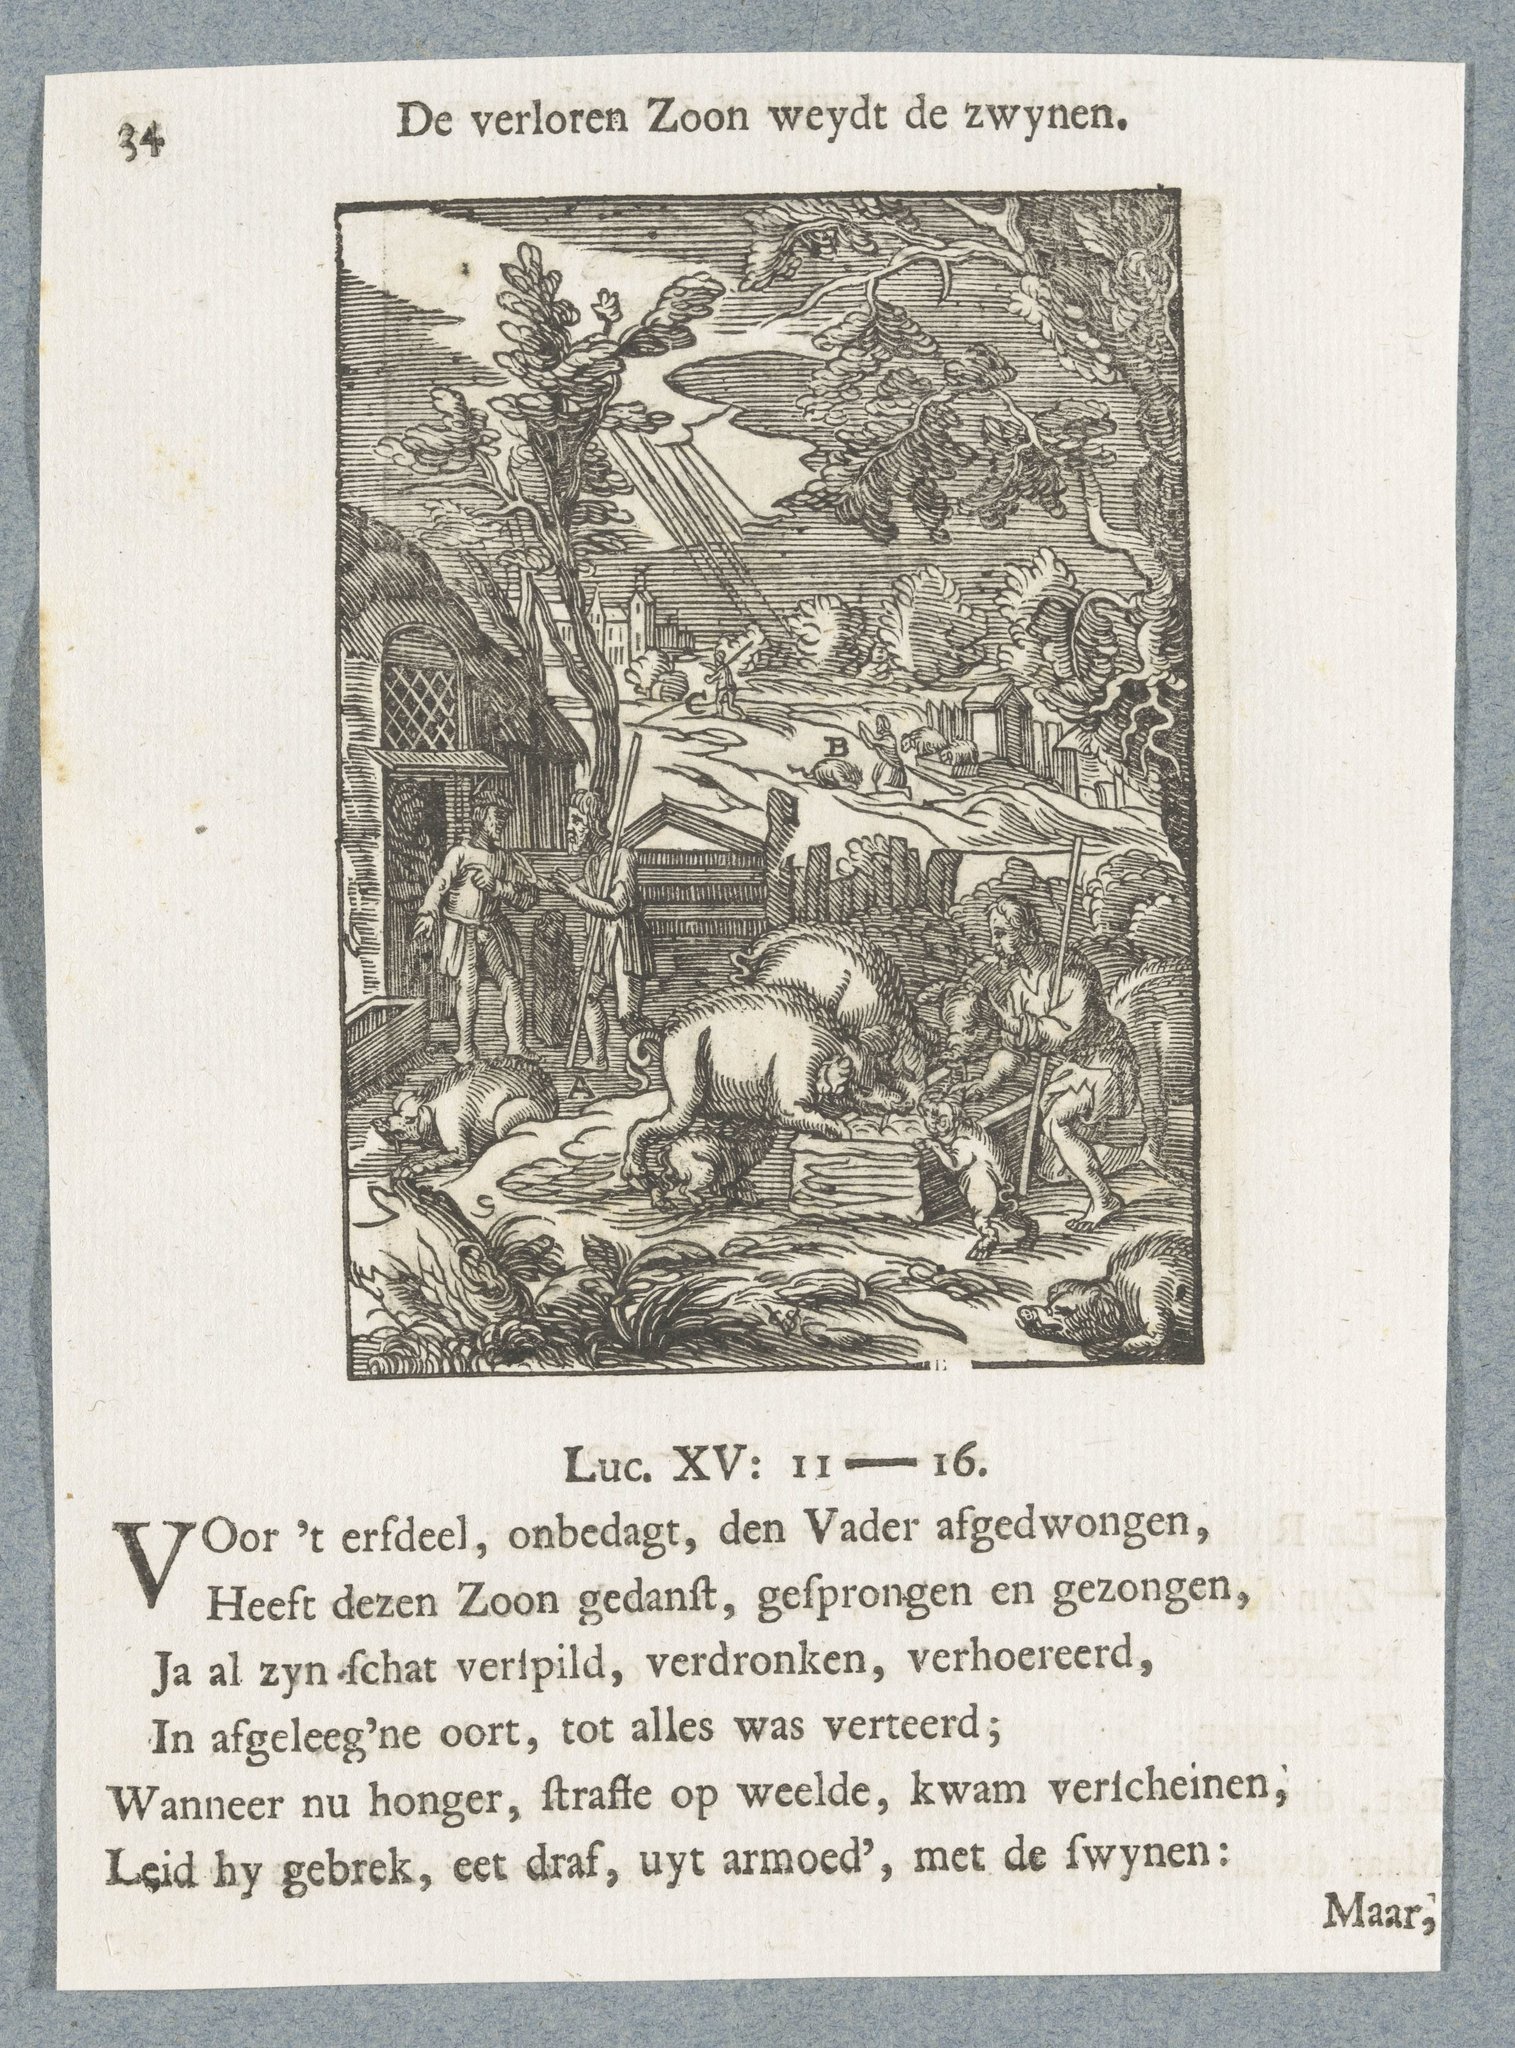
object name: print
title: Verloren zoon als varkenshoeder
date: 1629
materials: paper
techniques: letterpress printing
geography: amsterdam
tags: the prodigal son, suffering want, asks a farmer for work, the prodigal son repents his former life and prays, the prodigal son tends the swine and eats from their trough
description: De verloren zoon heeft zijn erfenis verkwist en verhuurt zichzelf bij een boer als varkenshoeder. Hij knielt tussen de varkens om met hen samen uit de voederbak te eten. Op de achtergrond komt hij tot inkeer en vertrekt hij naar zijn vader. Bij verschillende elementen uit de voorstelling staan letters. Boven de voorstelling een titel. Eronder zes versregels en een verwijzing naar Lucas 15: 11-16. De prent maakt deel uit van een album.